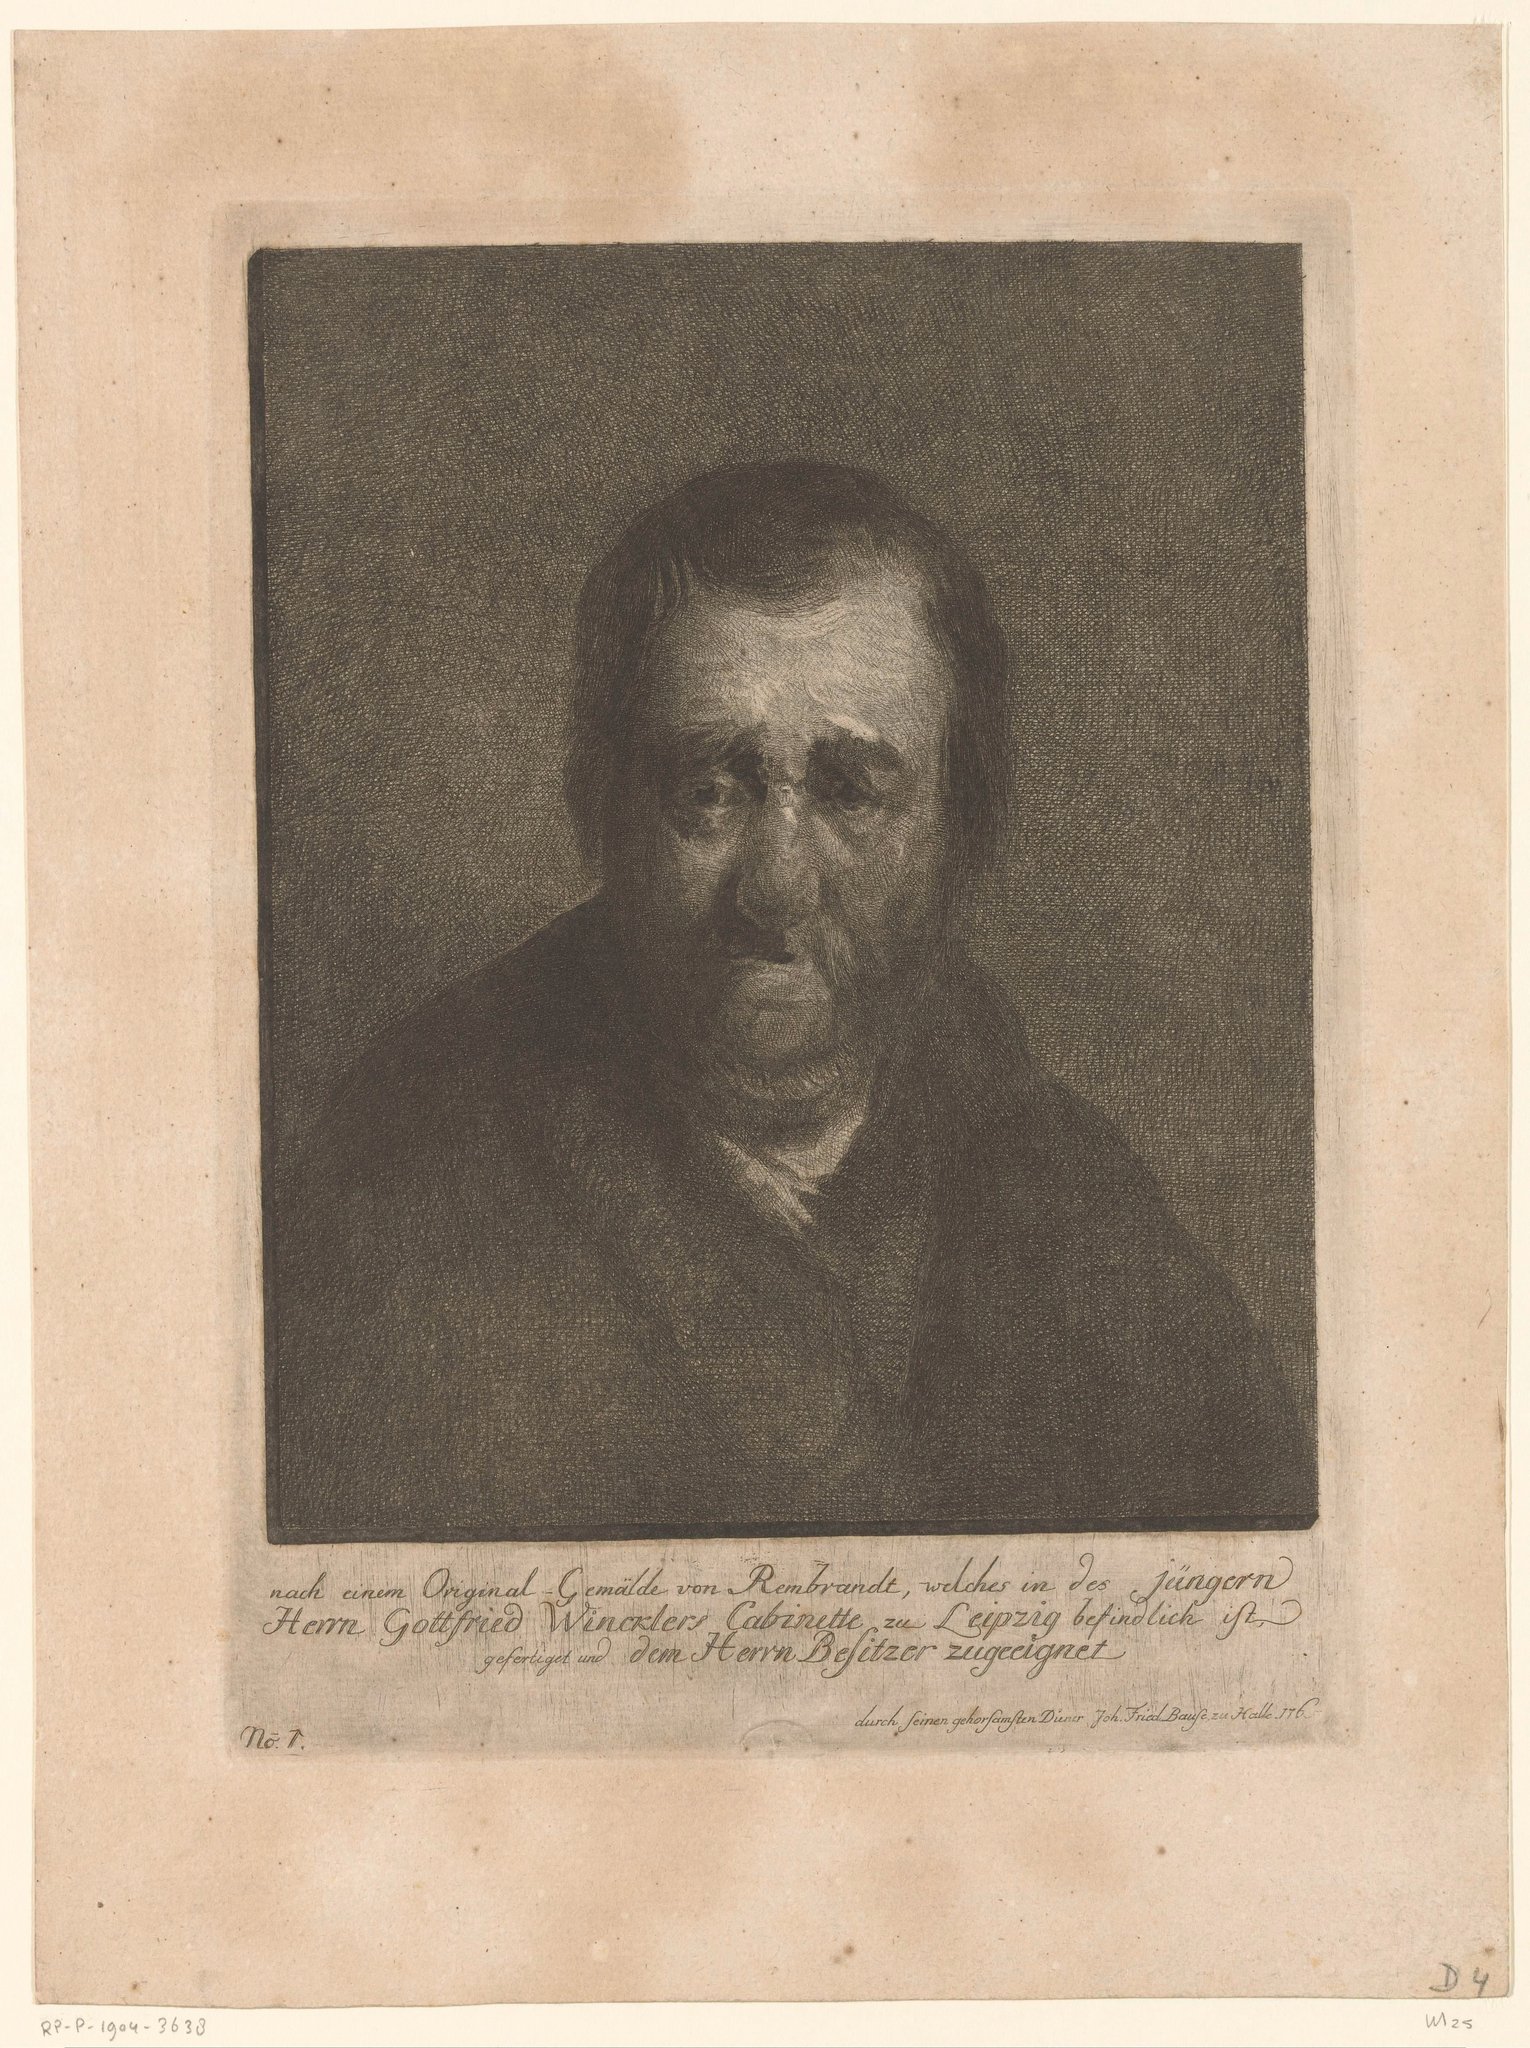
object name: print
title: Oude man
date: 1765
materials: paper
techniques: etching, intaglio, roulette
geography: leipzig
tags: old man, anonymous historical person portrayed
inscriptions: collector's mark: Lugt 2228, check stamp